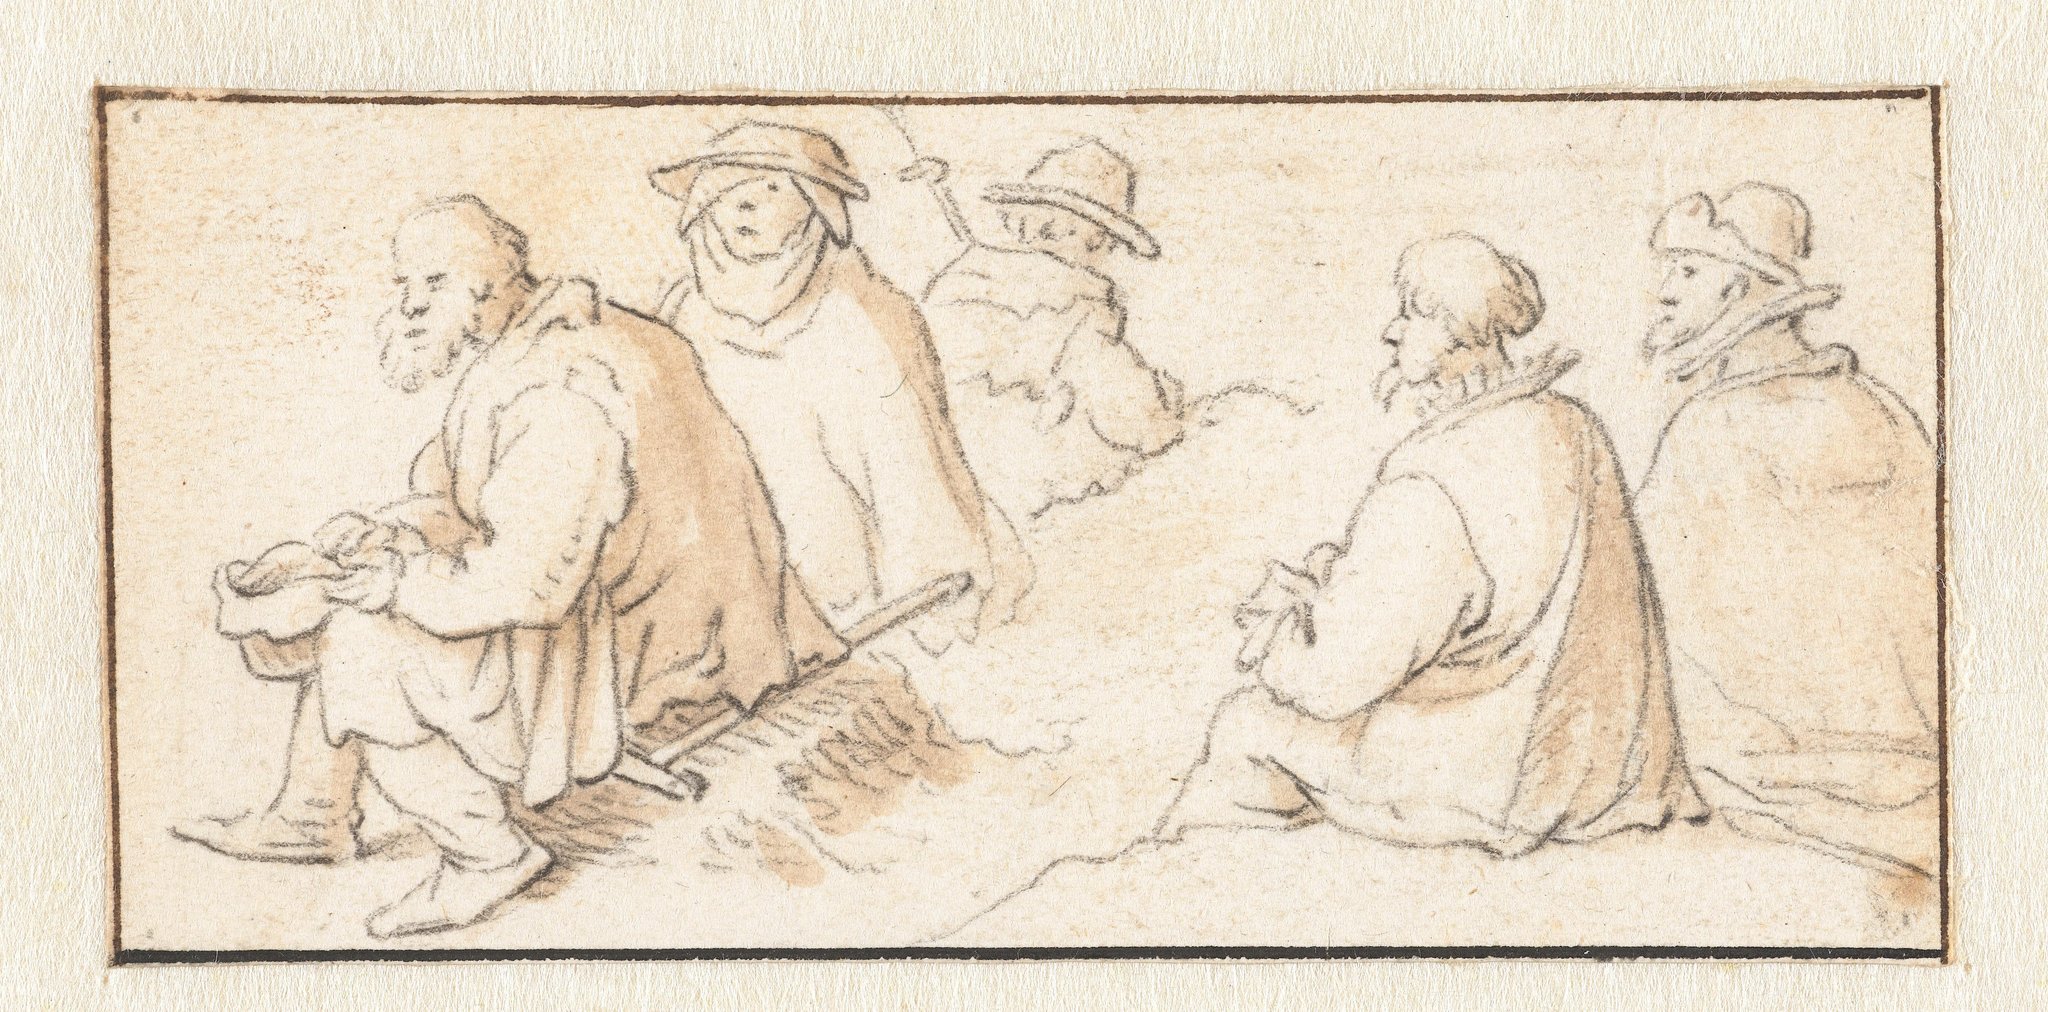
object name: drawing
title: Vijf zittende mannen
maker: herman saftleven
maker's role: draughtsman, painter, print maker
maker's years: 1609-1685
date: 1619-1685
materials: chalk, paper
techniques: brush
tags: sitting figure